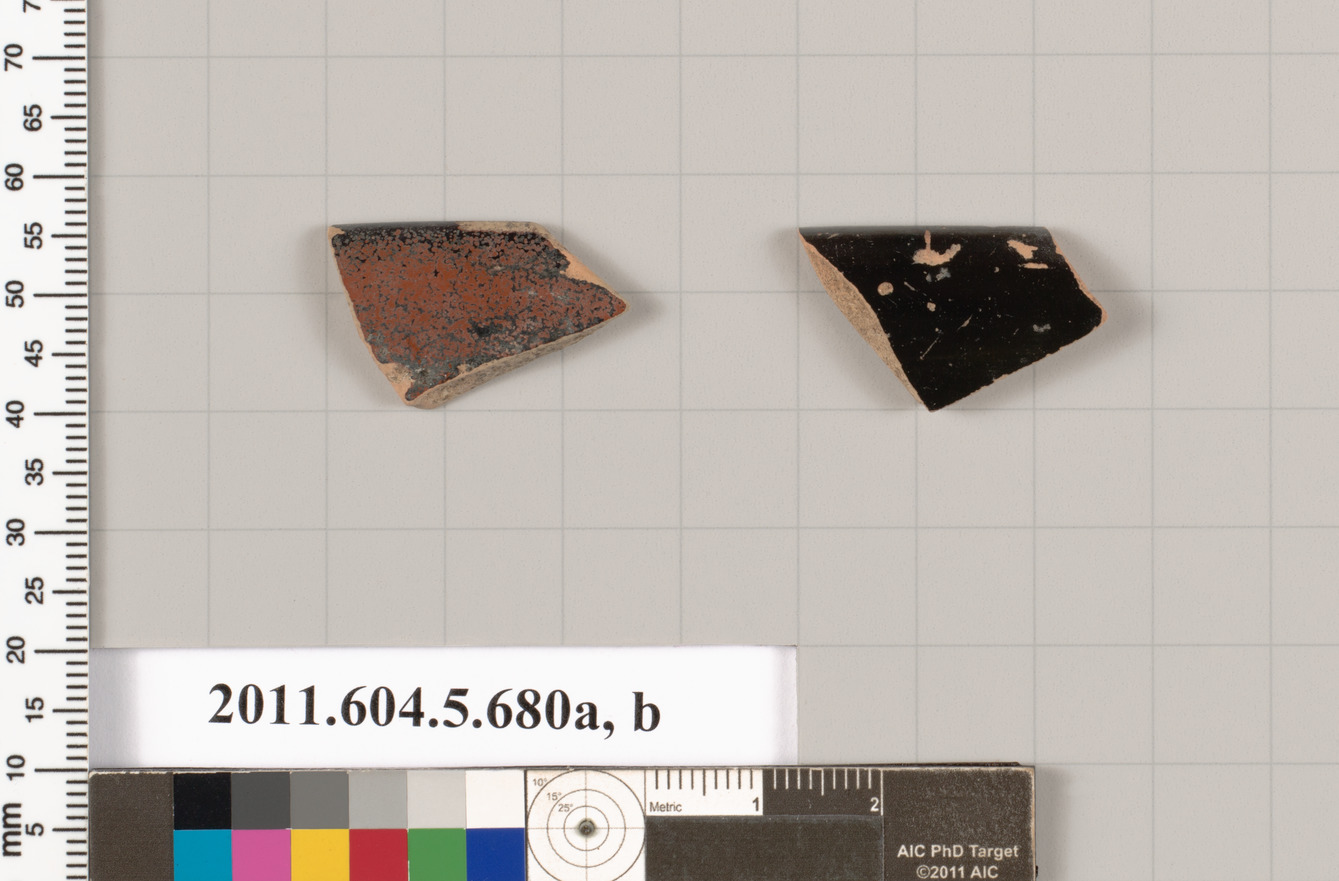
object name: kylix fragment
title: Terracotta rim fragments of kylikes (drinking cups)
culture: greek, attic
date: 600-401 BCE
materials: terracotta